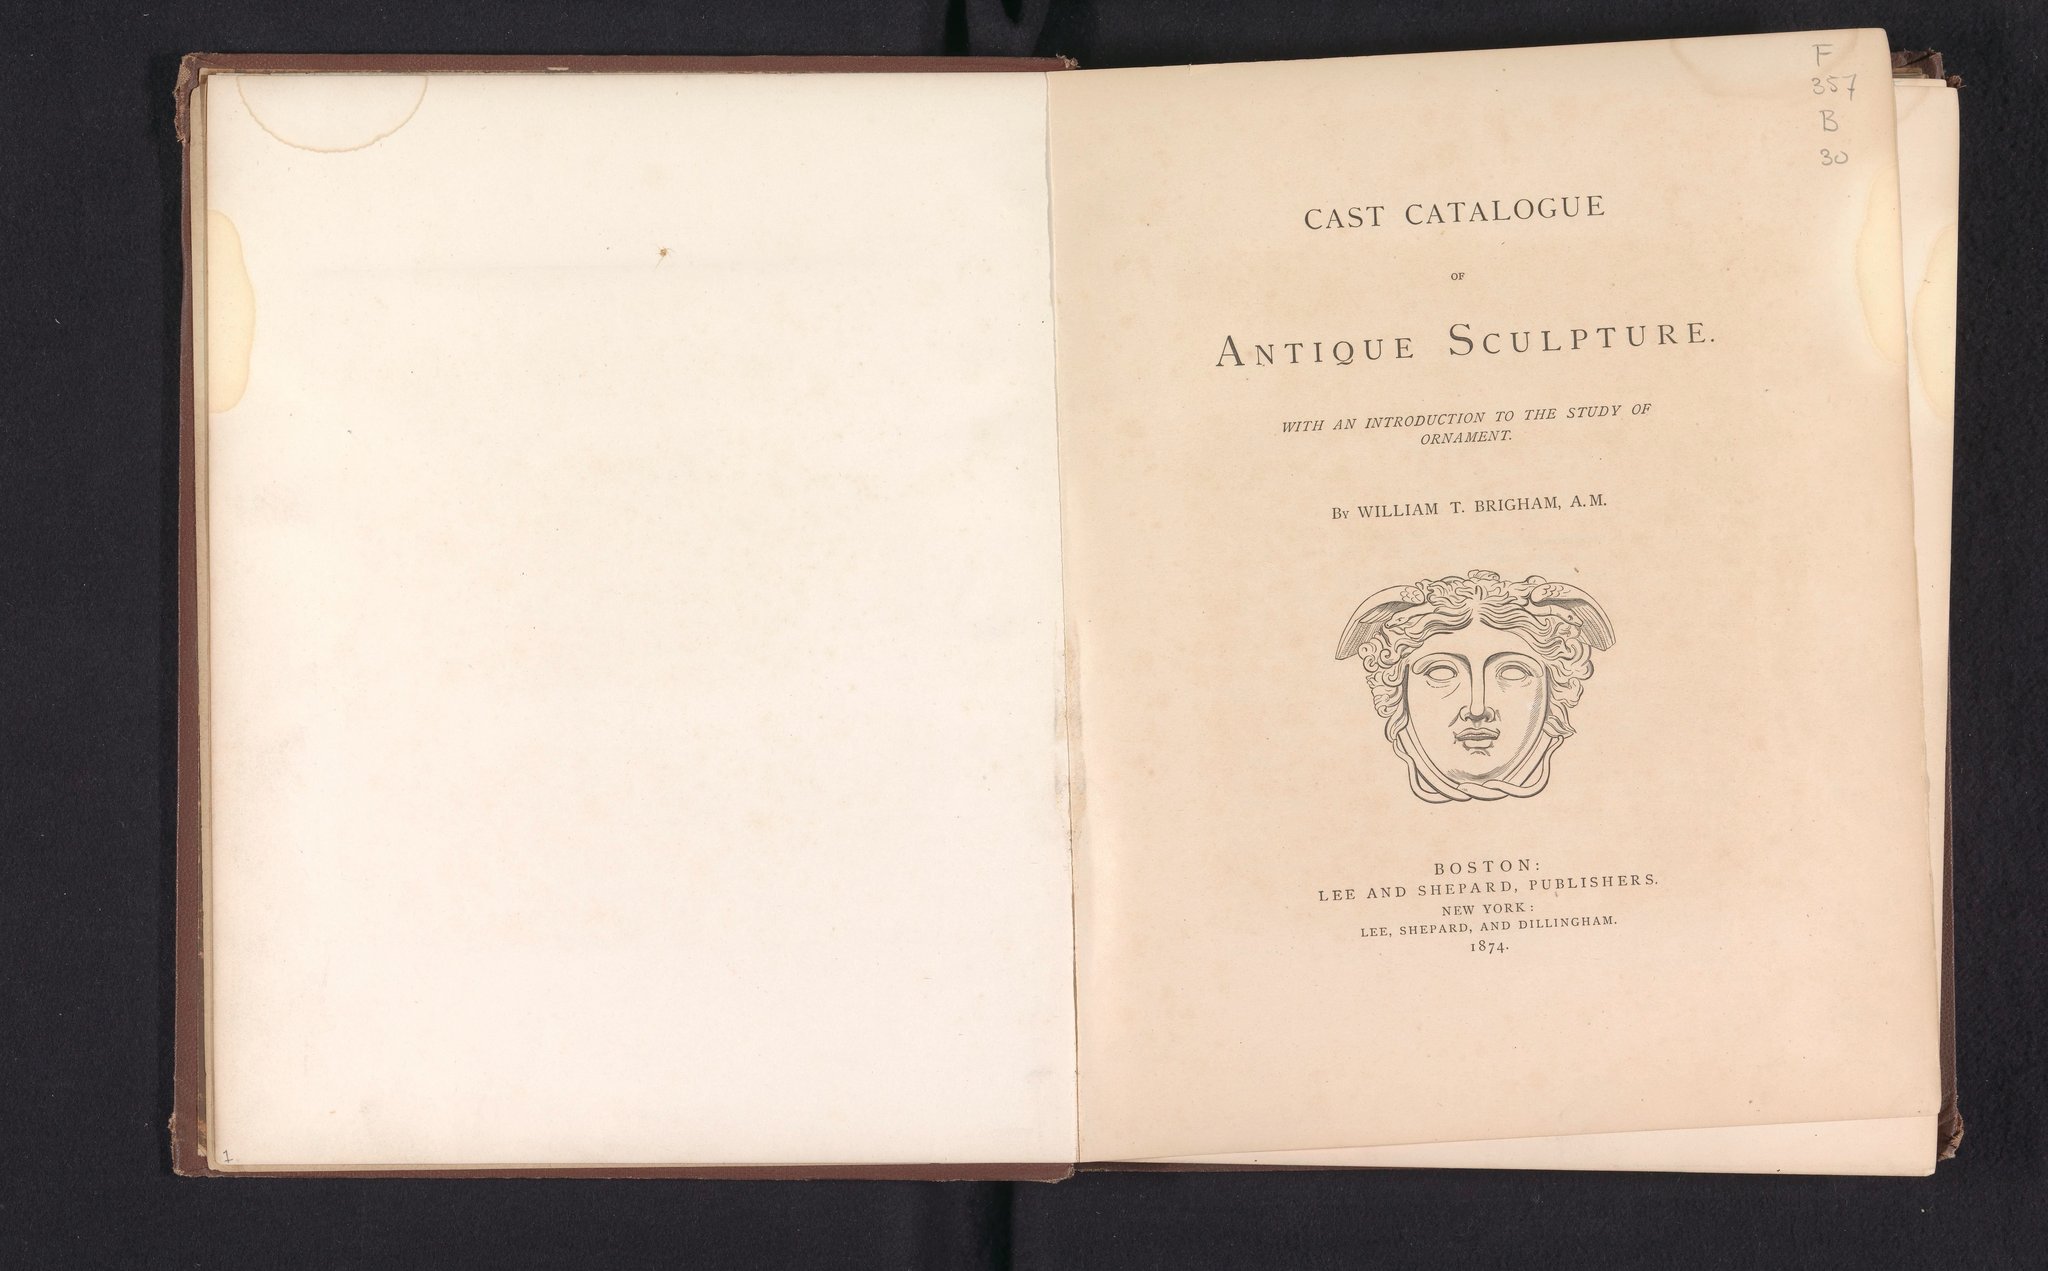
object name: book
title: Cast catalogue of antique sculpture with an introduction to the study of ornament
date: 1874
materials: cardboard, linen, paper, photographic support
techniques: albumen print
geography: new york city